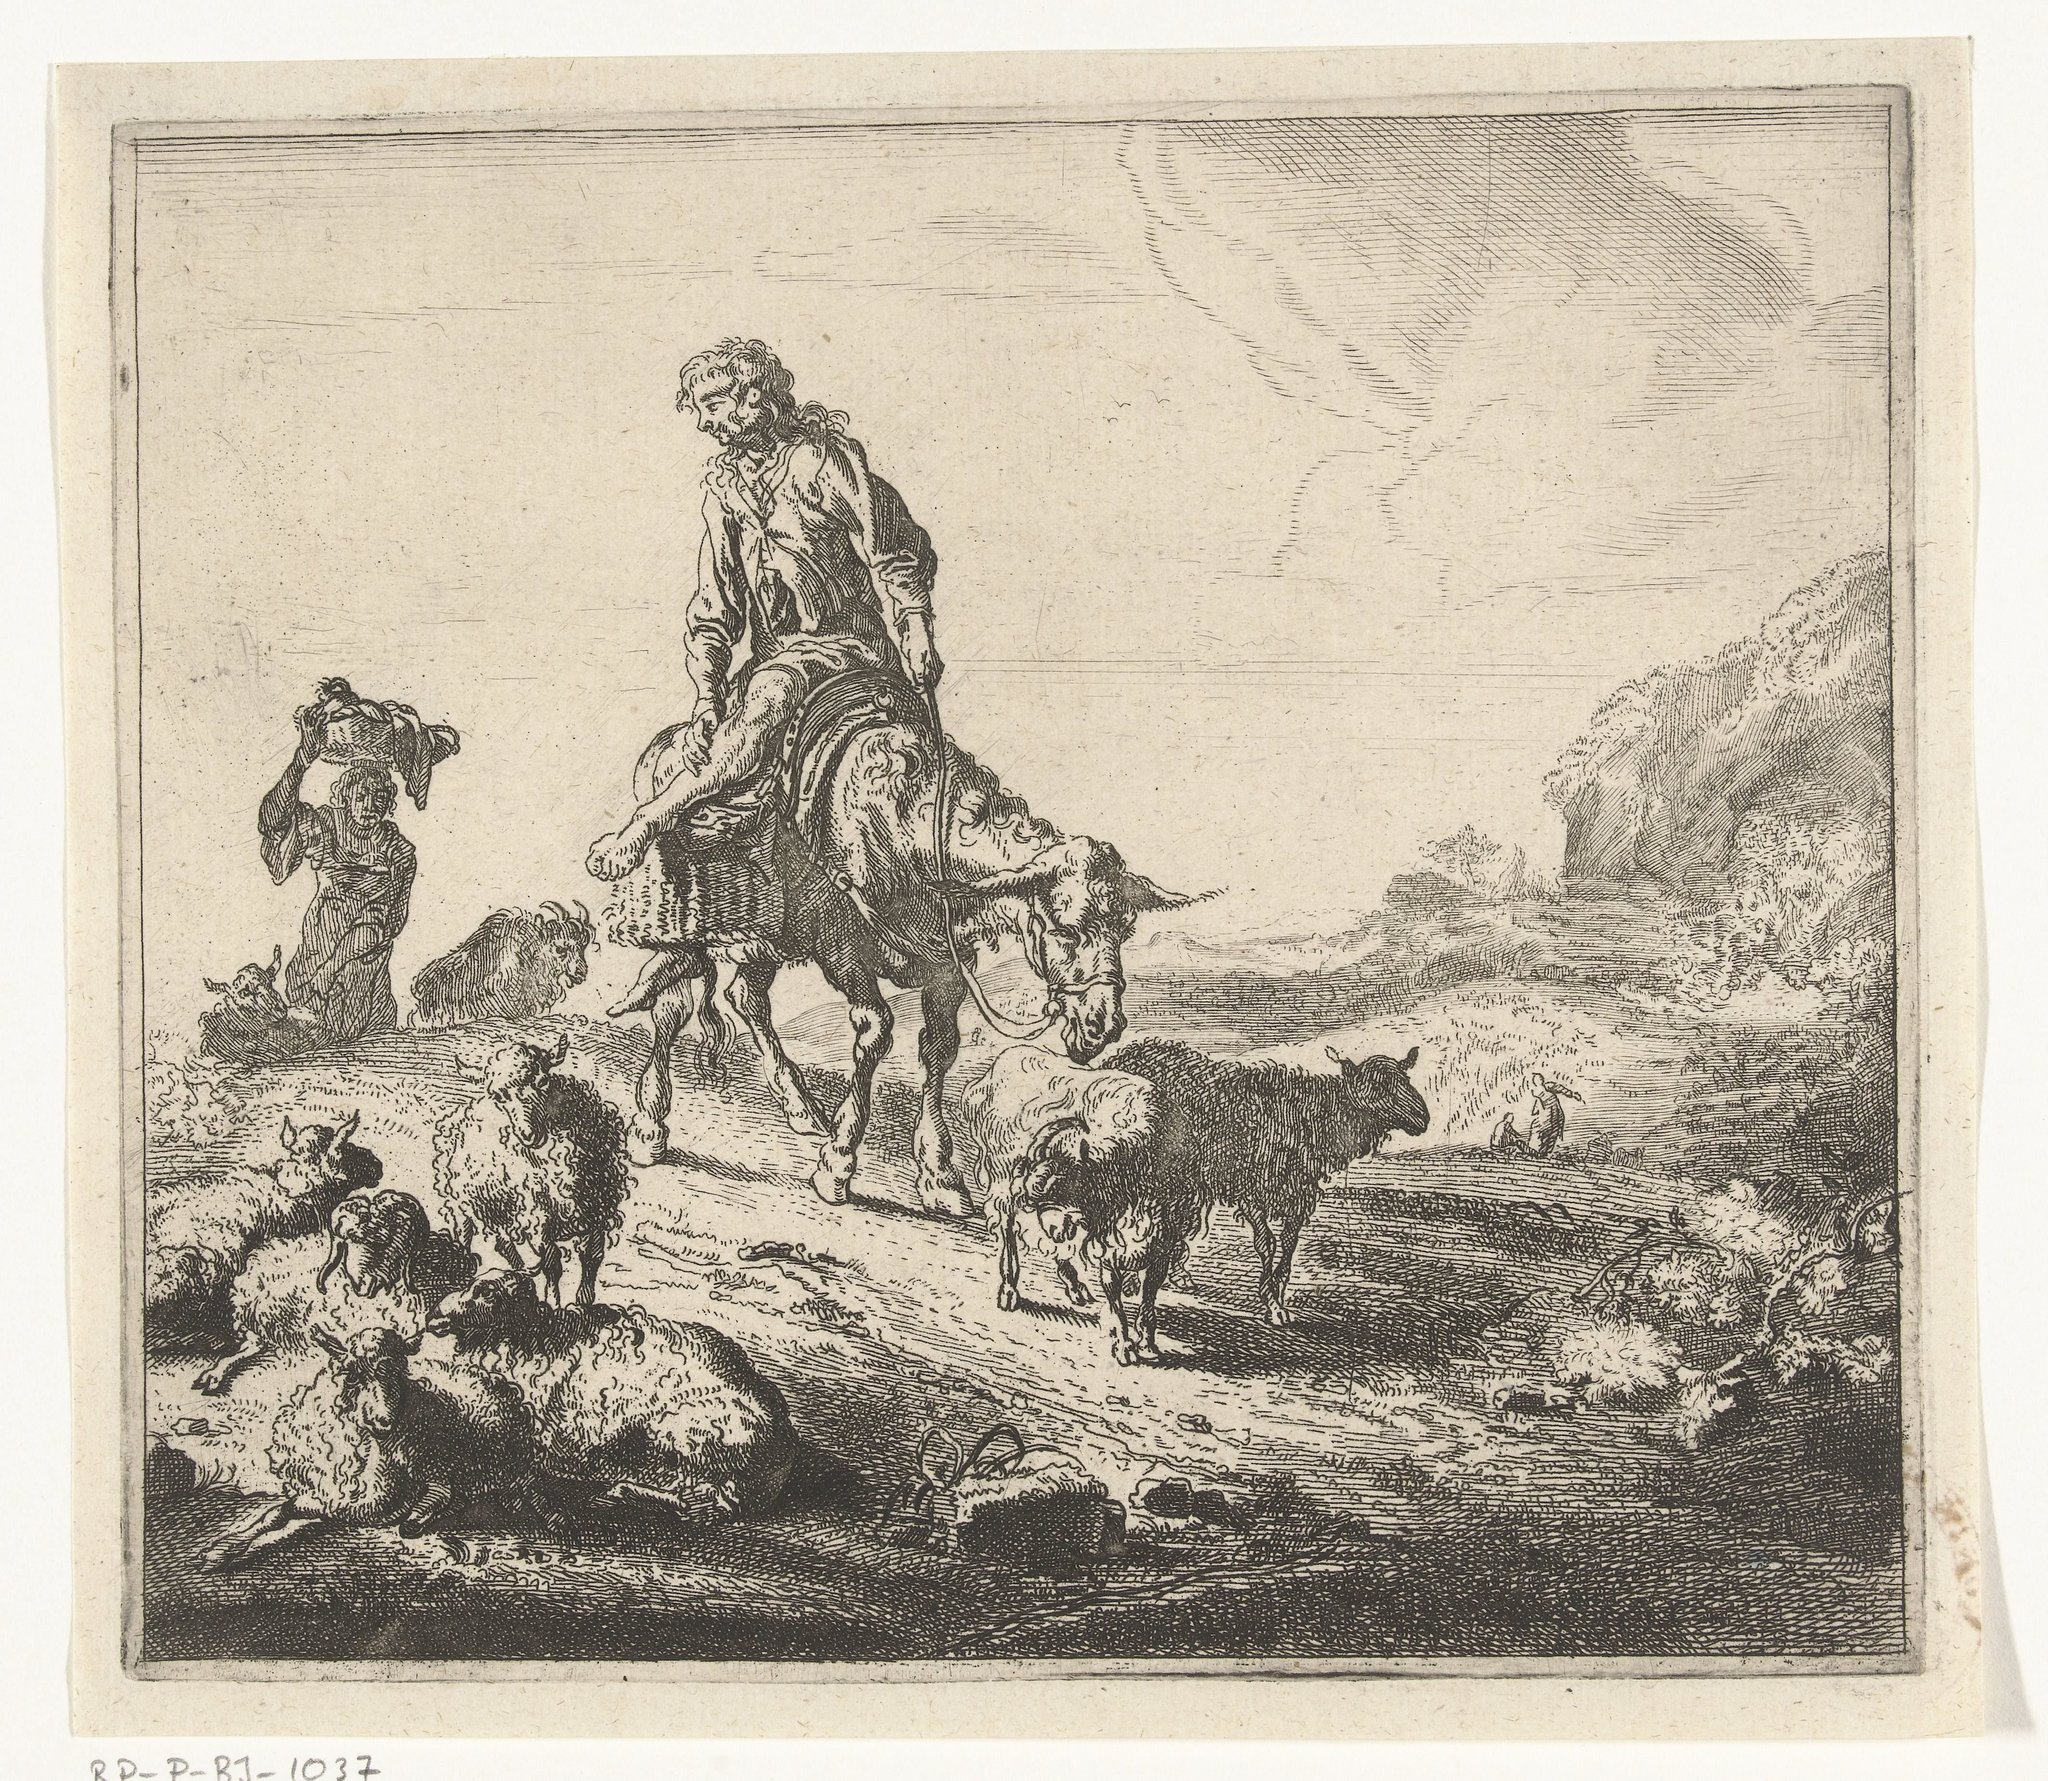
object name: print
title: Man op een ezel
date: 1644-1733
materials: paper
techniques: etching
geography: netherlands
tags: ass, donkey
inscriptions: collector's mark: Lugt 240